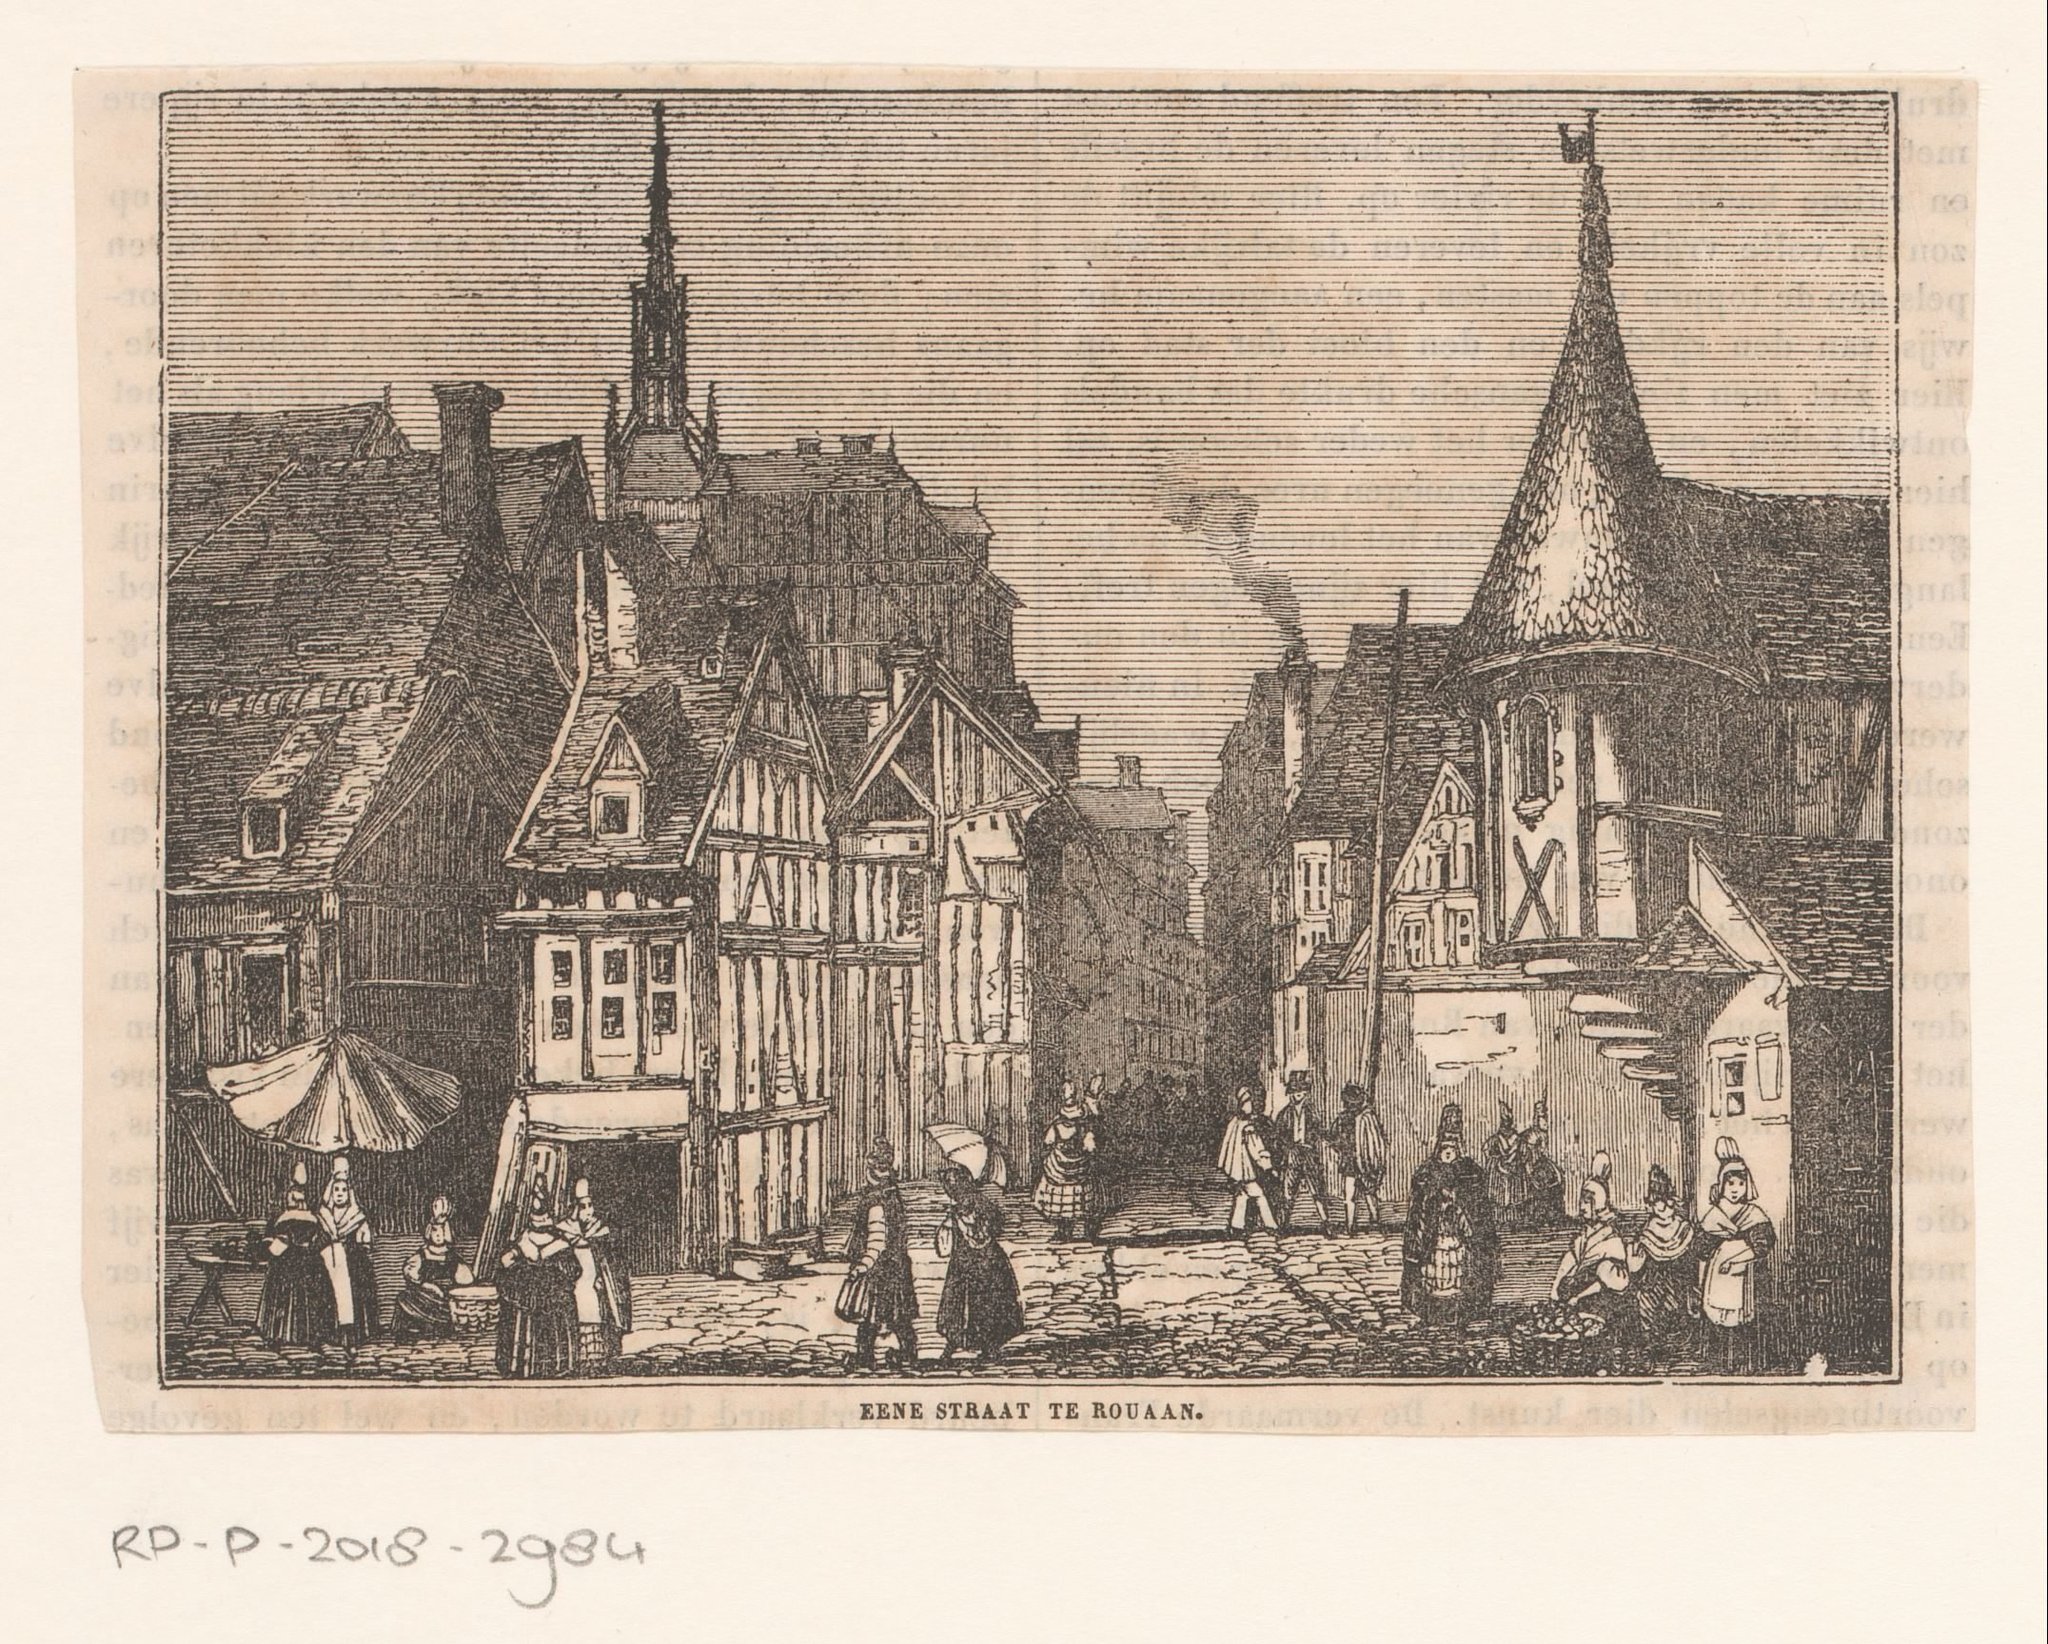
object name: book illustration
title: Gezicht op Rouen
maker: Anonymous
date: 1837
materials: paper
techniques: letterpress printing, engraving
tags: street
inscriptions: collector's mark: Lugt 2228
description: Prent uit: Nederlandsch Magazijn (1837), p. 245.